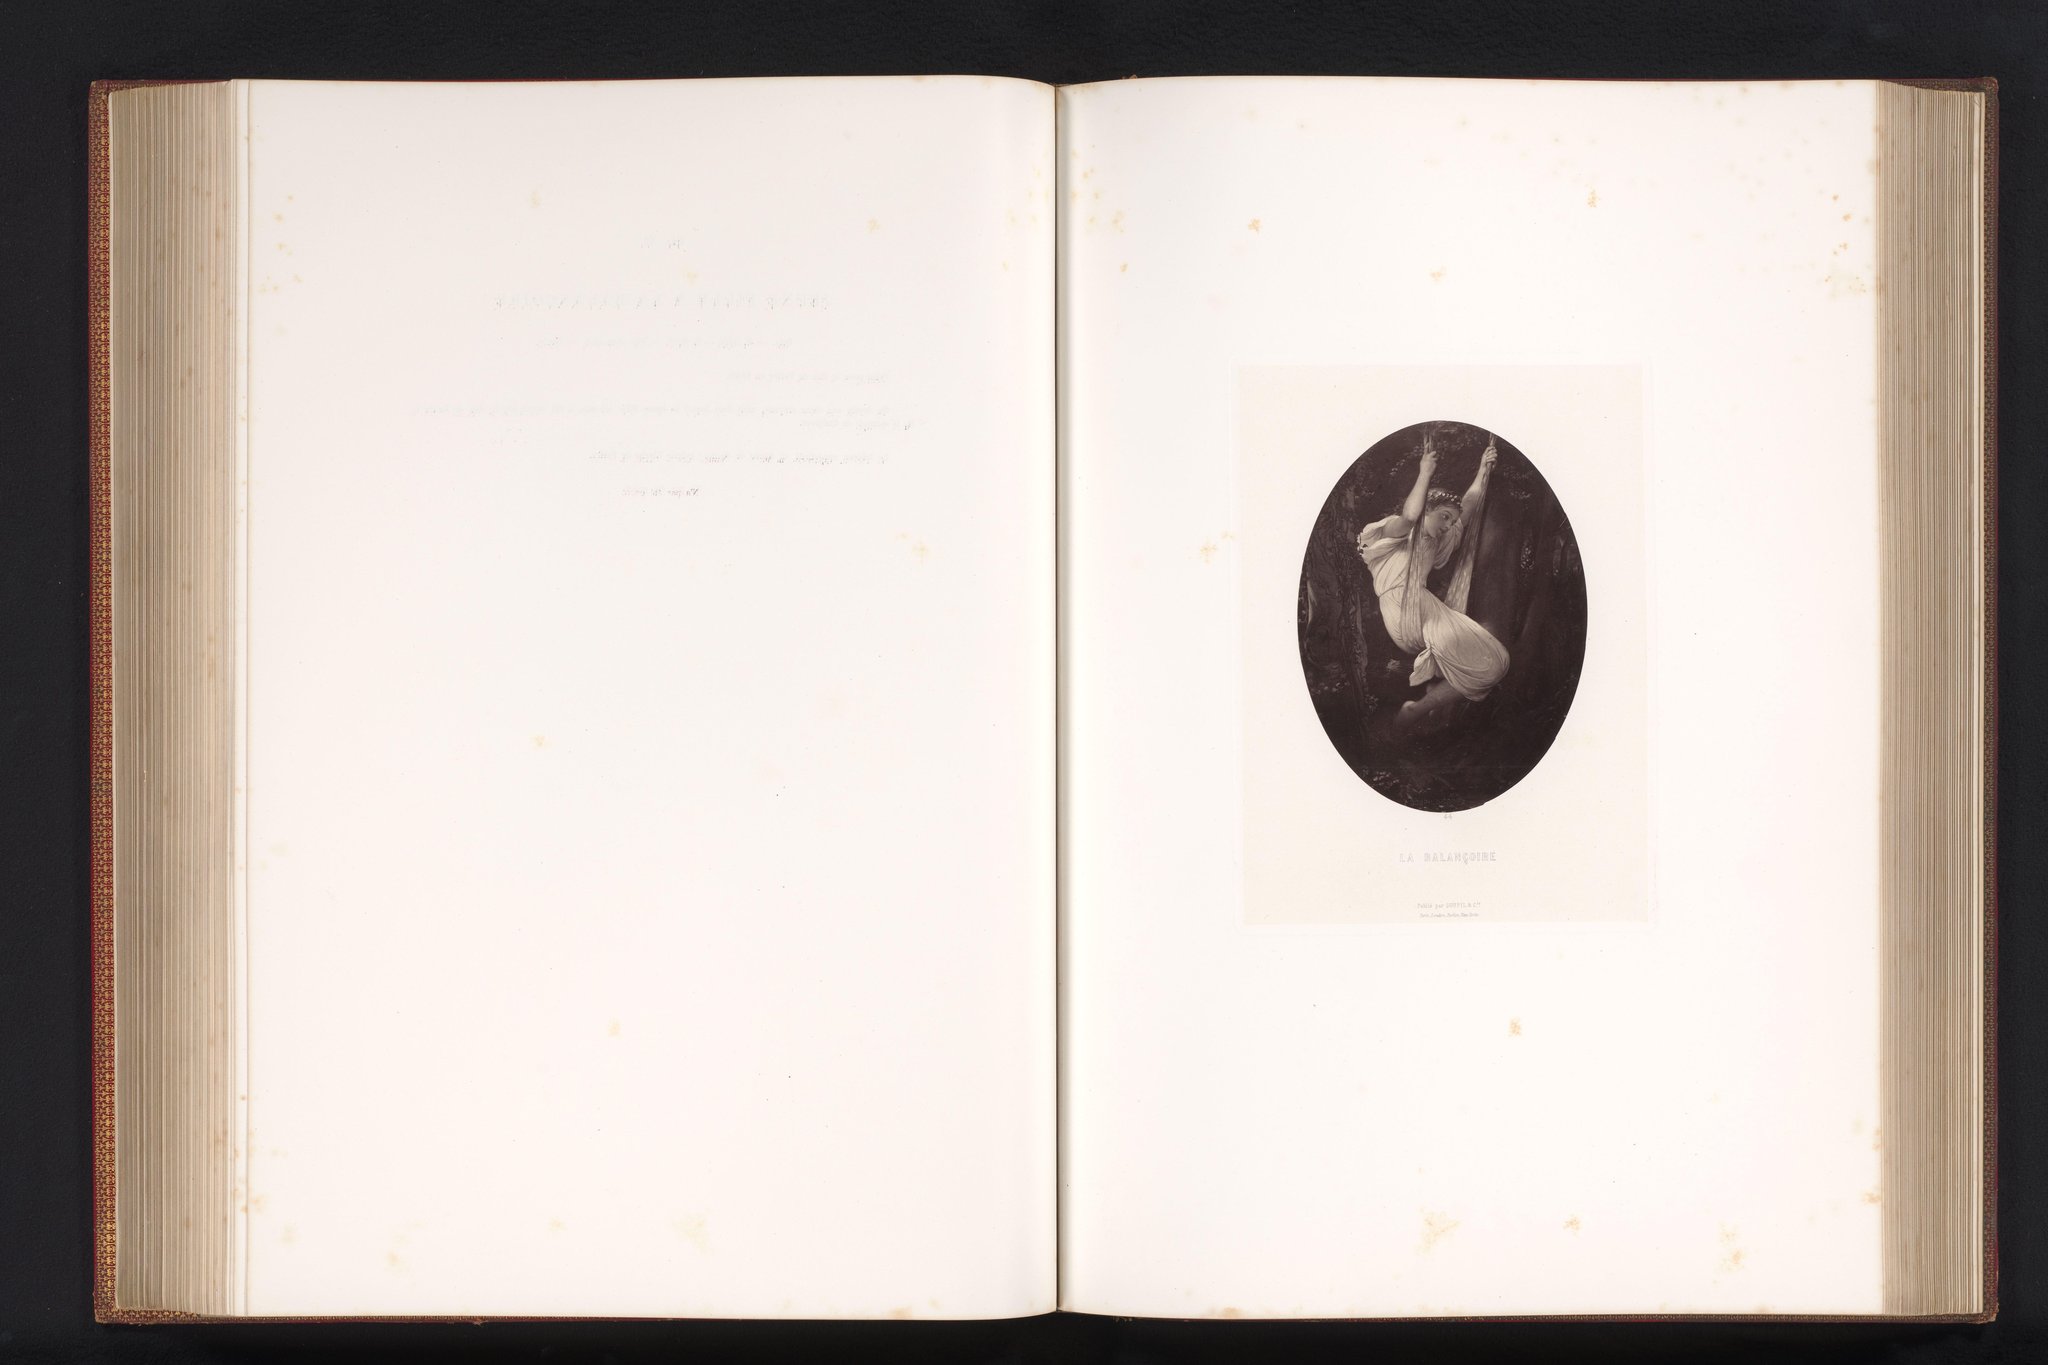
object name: page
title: Jeune fille à la balançoire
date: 1853-1858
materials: paper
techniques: albumen print, engraving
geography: paris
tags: girl (child between toddler and youth), swing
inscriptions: check stamp: ‘Goupil & Compie.’